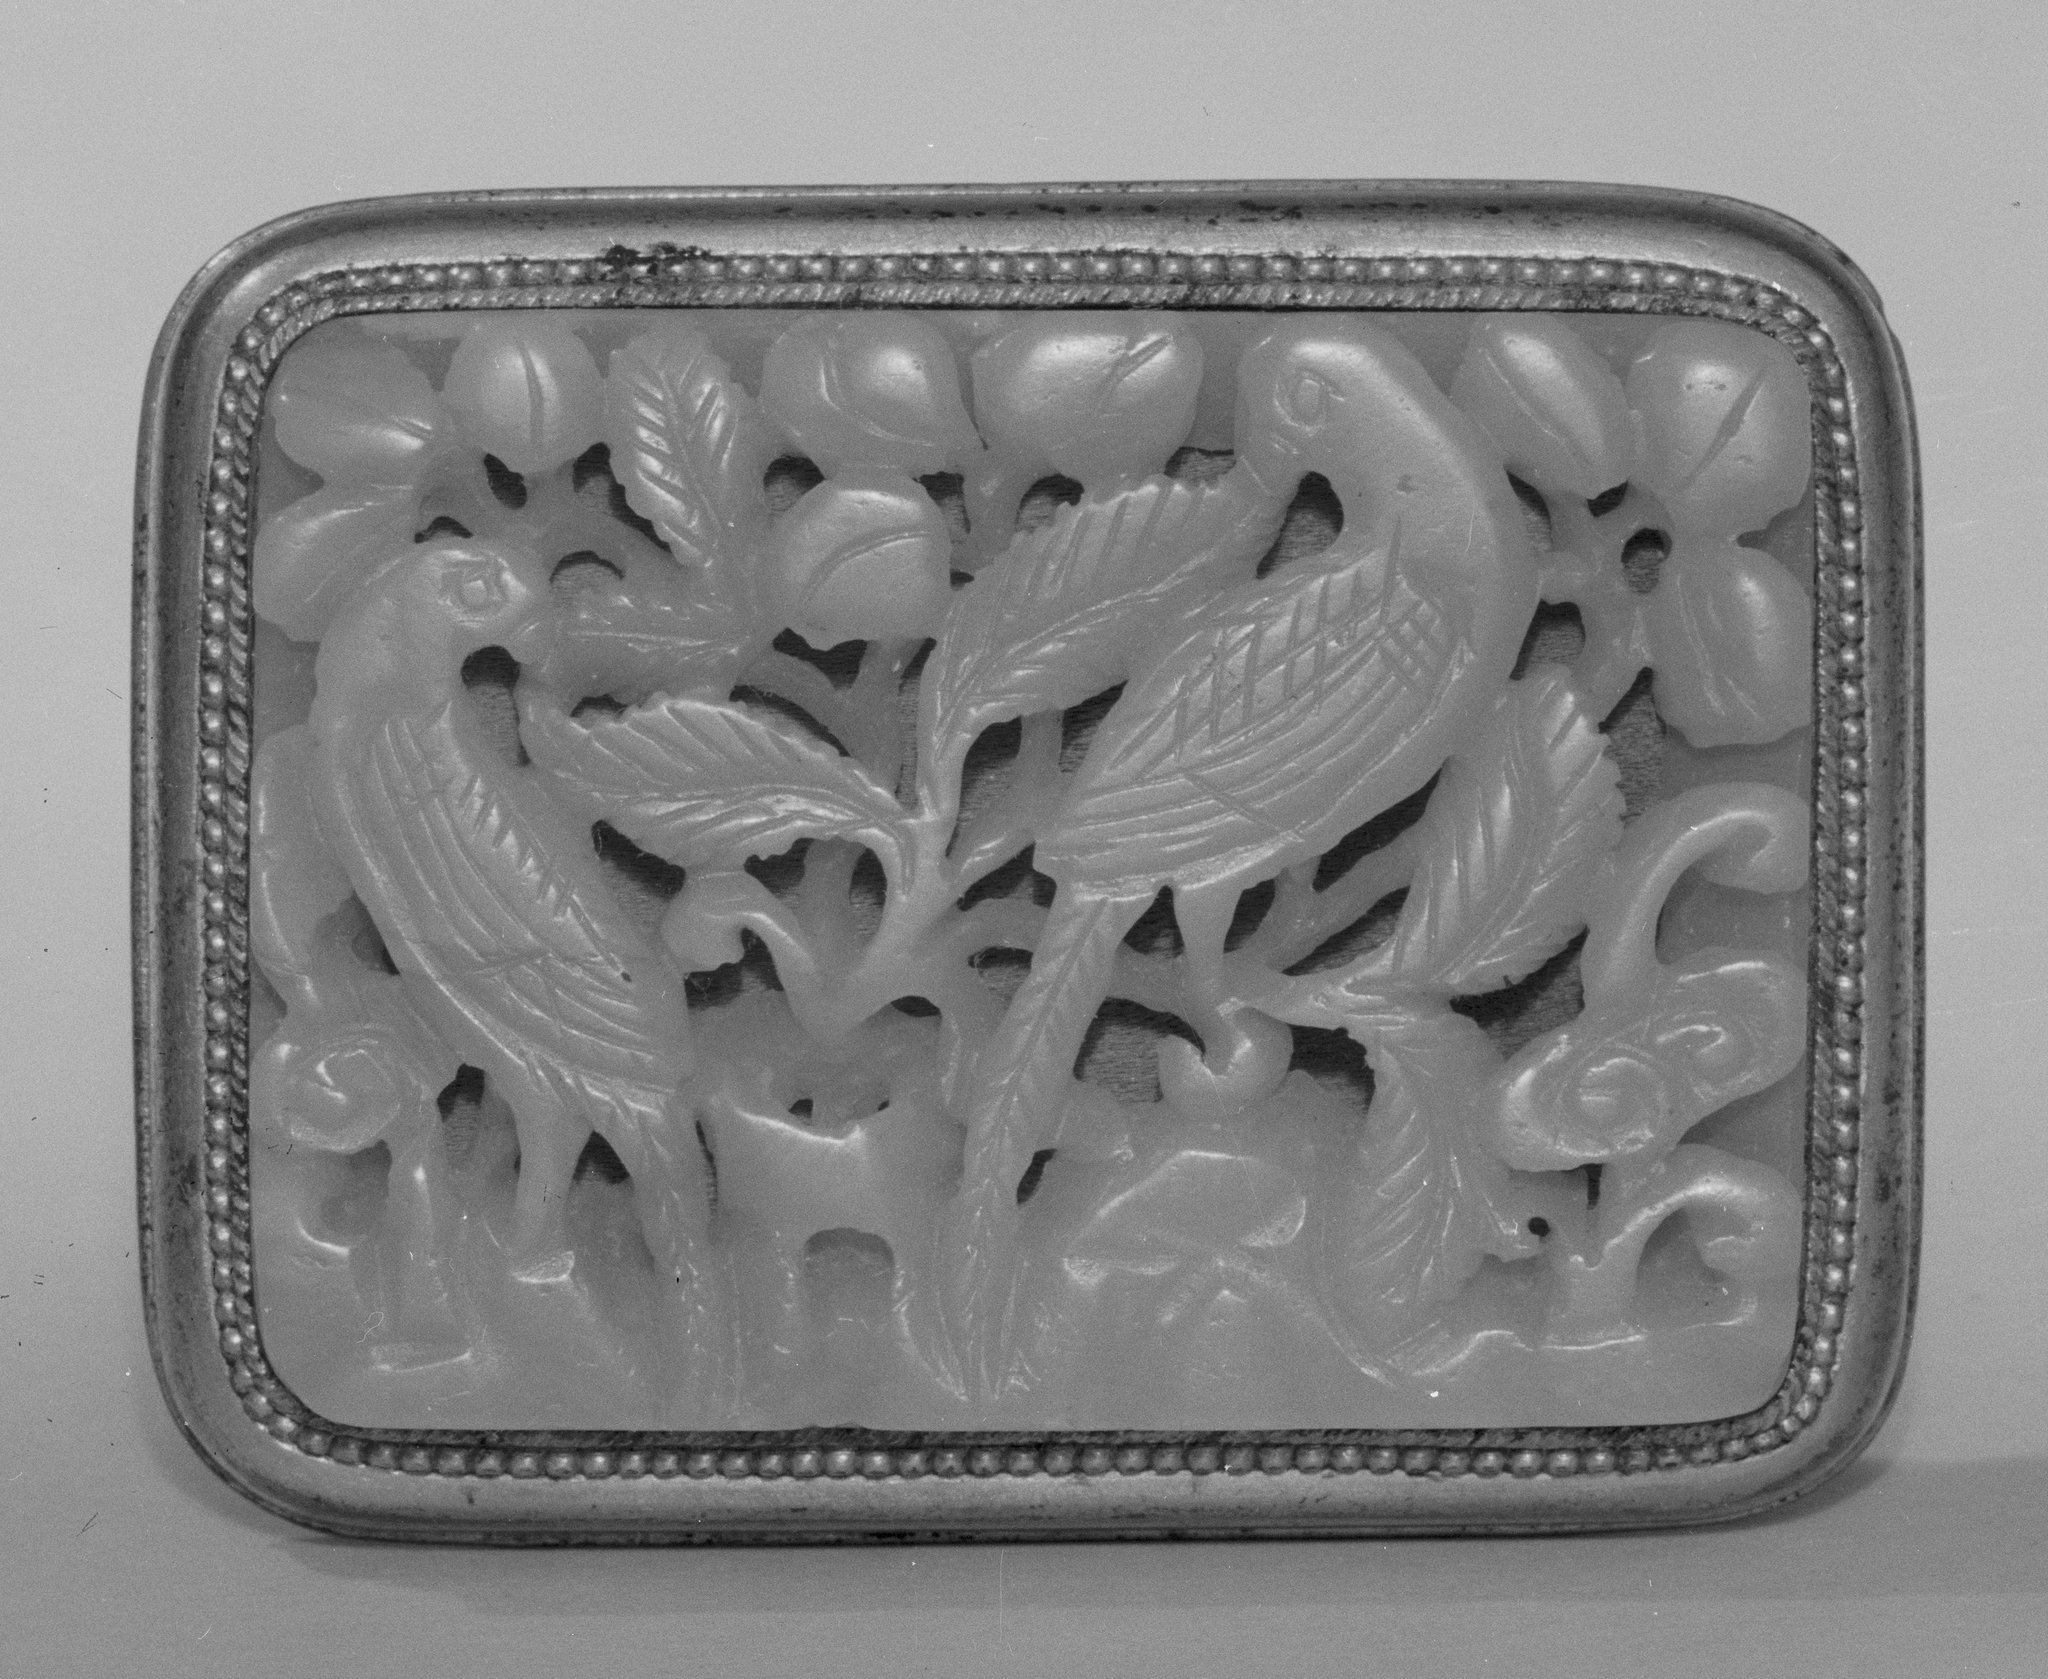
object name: buckle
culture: chinese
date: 1701-1800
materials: gilt bronze, jade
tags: birds